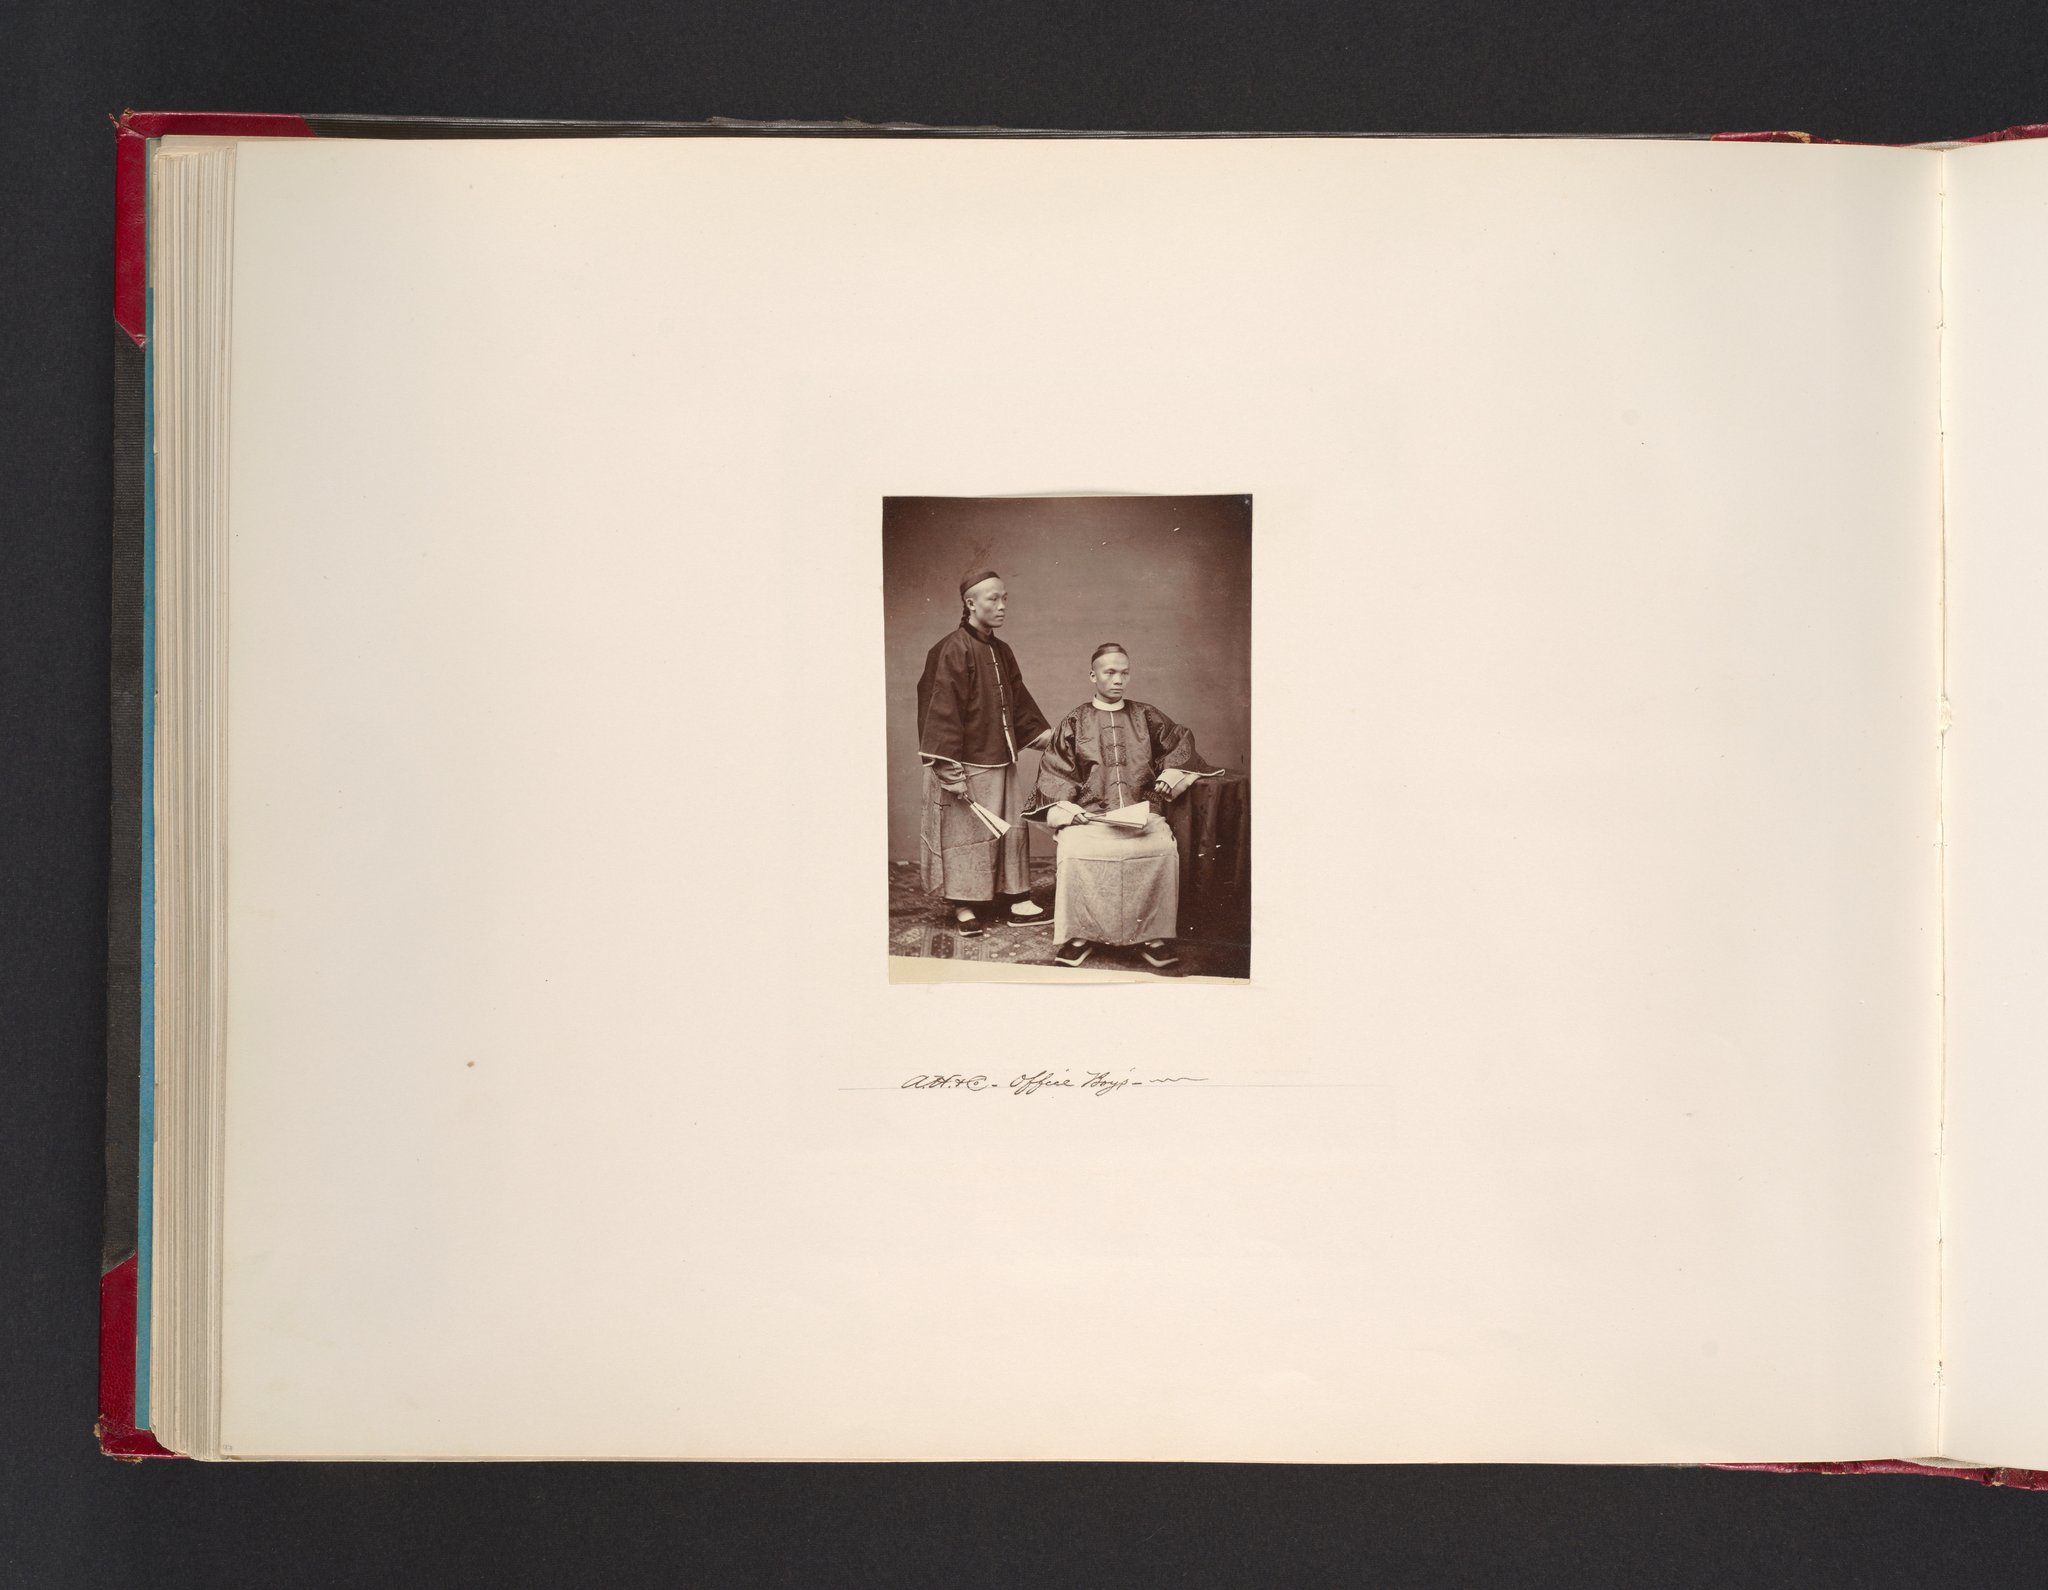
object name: photograph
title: Augustine Heard & Co. Office Boys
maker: john thomson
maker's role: artist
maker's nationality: british, scottish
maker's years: 1837-1921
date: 1865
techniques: albumen silver print, glass negative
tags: fans,men,portraits